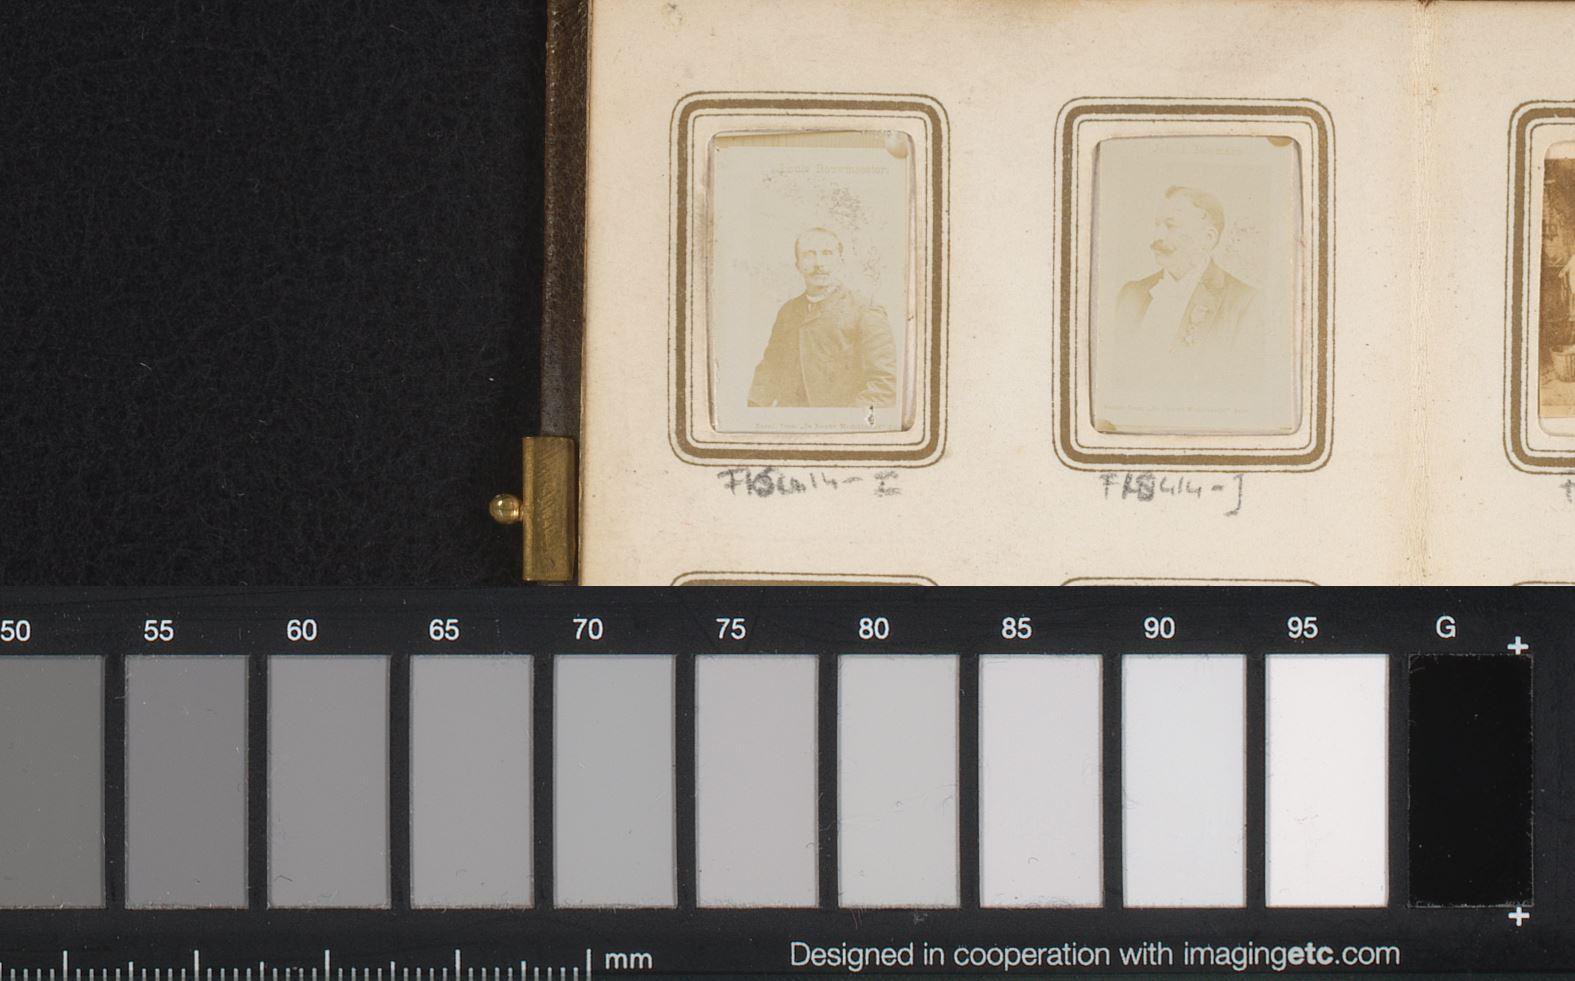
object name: photograph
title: Miniatuurportret van Louis Bouwmeester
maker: Anonymous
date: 1880-1910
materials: paper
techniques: collodion silver print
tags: adult man